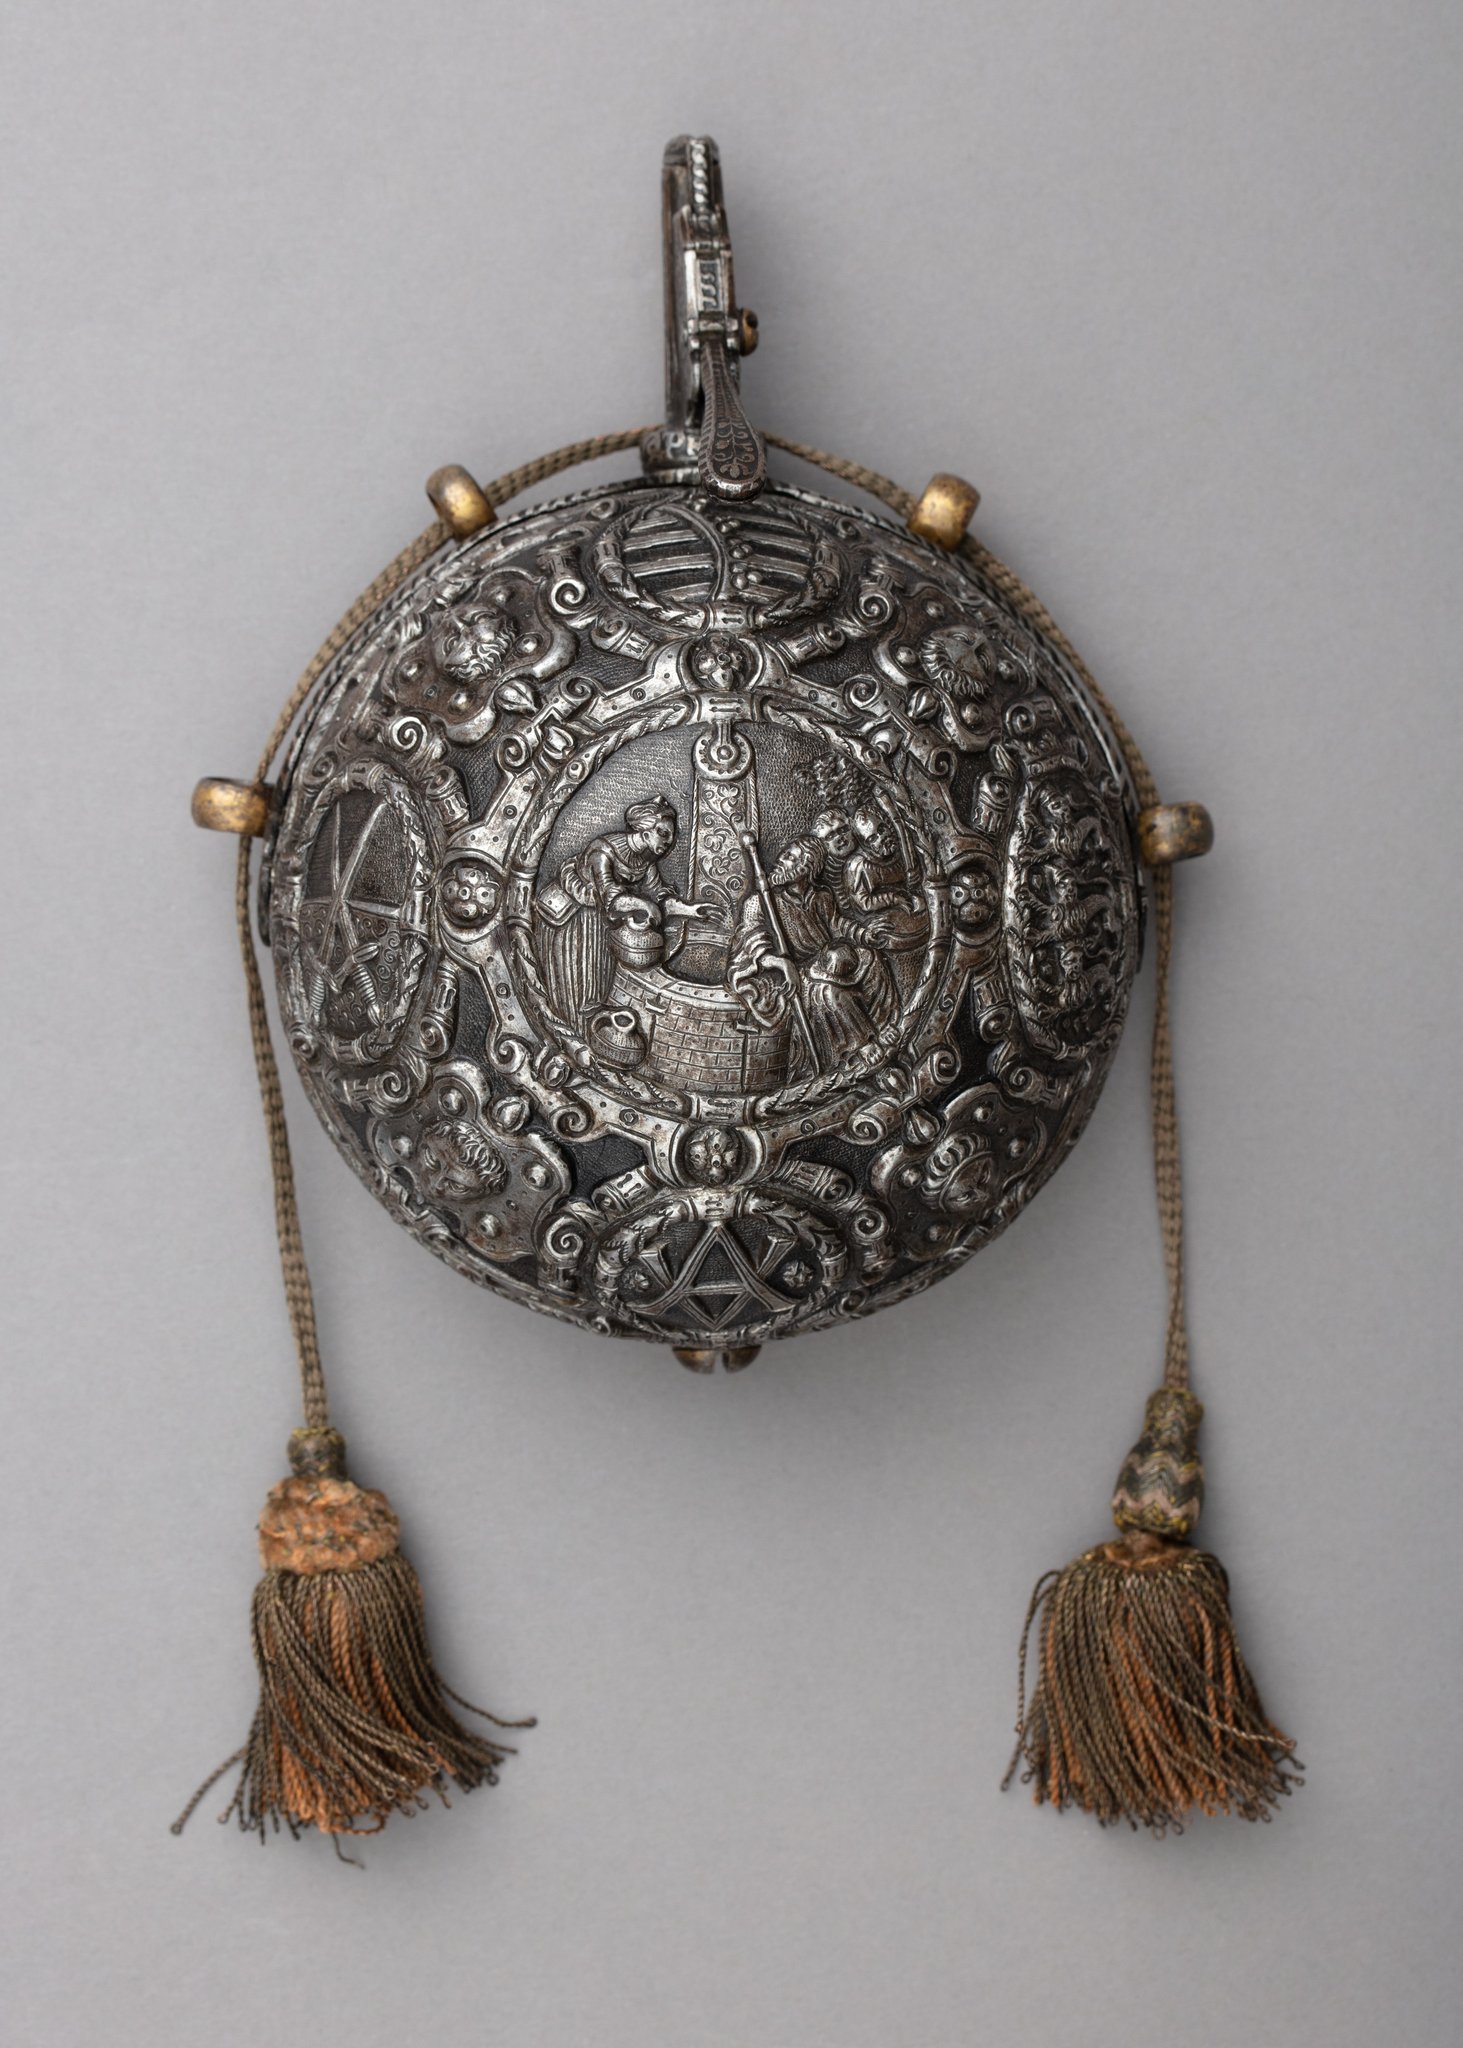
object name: priming flask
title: Priming Flask Bearing the Monograms and Arms of the Prince-Elector August I of Saxony (reigned 1553–86) and Anna of Denmark (reigned 1553–85)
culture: german, saxony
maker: master thomas der schwertfeger (possibly thomas rucker)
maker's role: iron-chiseler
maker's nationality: german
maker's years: 1535-1606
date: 1575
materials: gold, iron, silk, silver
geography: germany